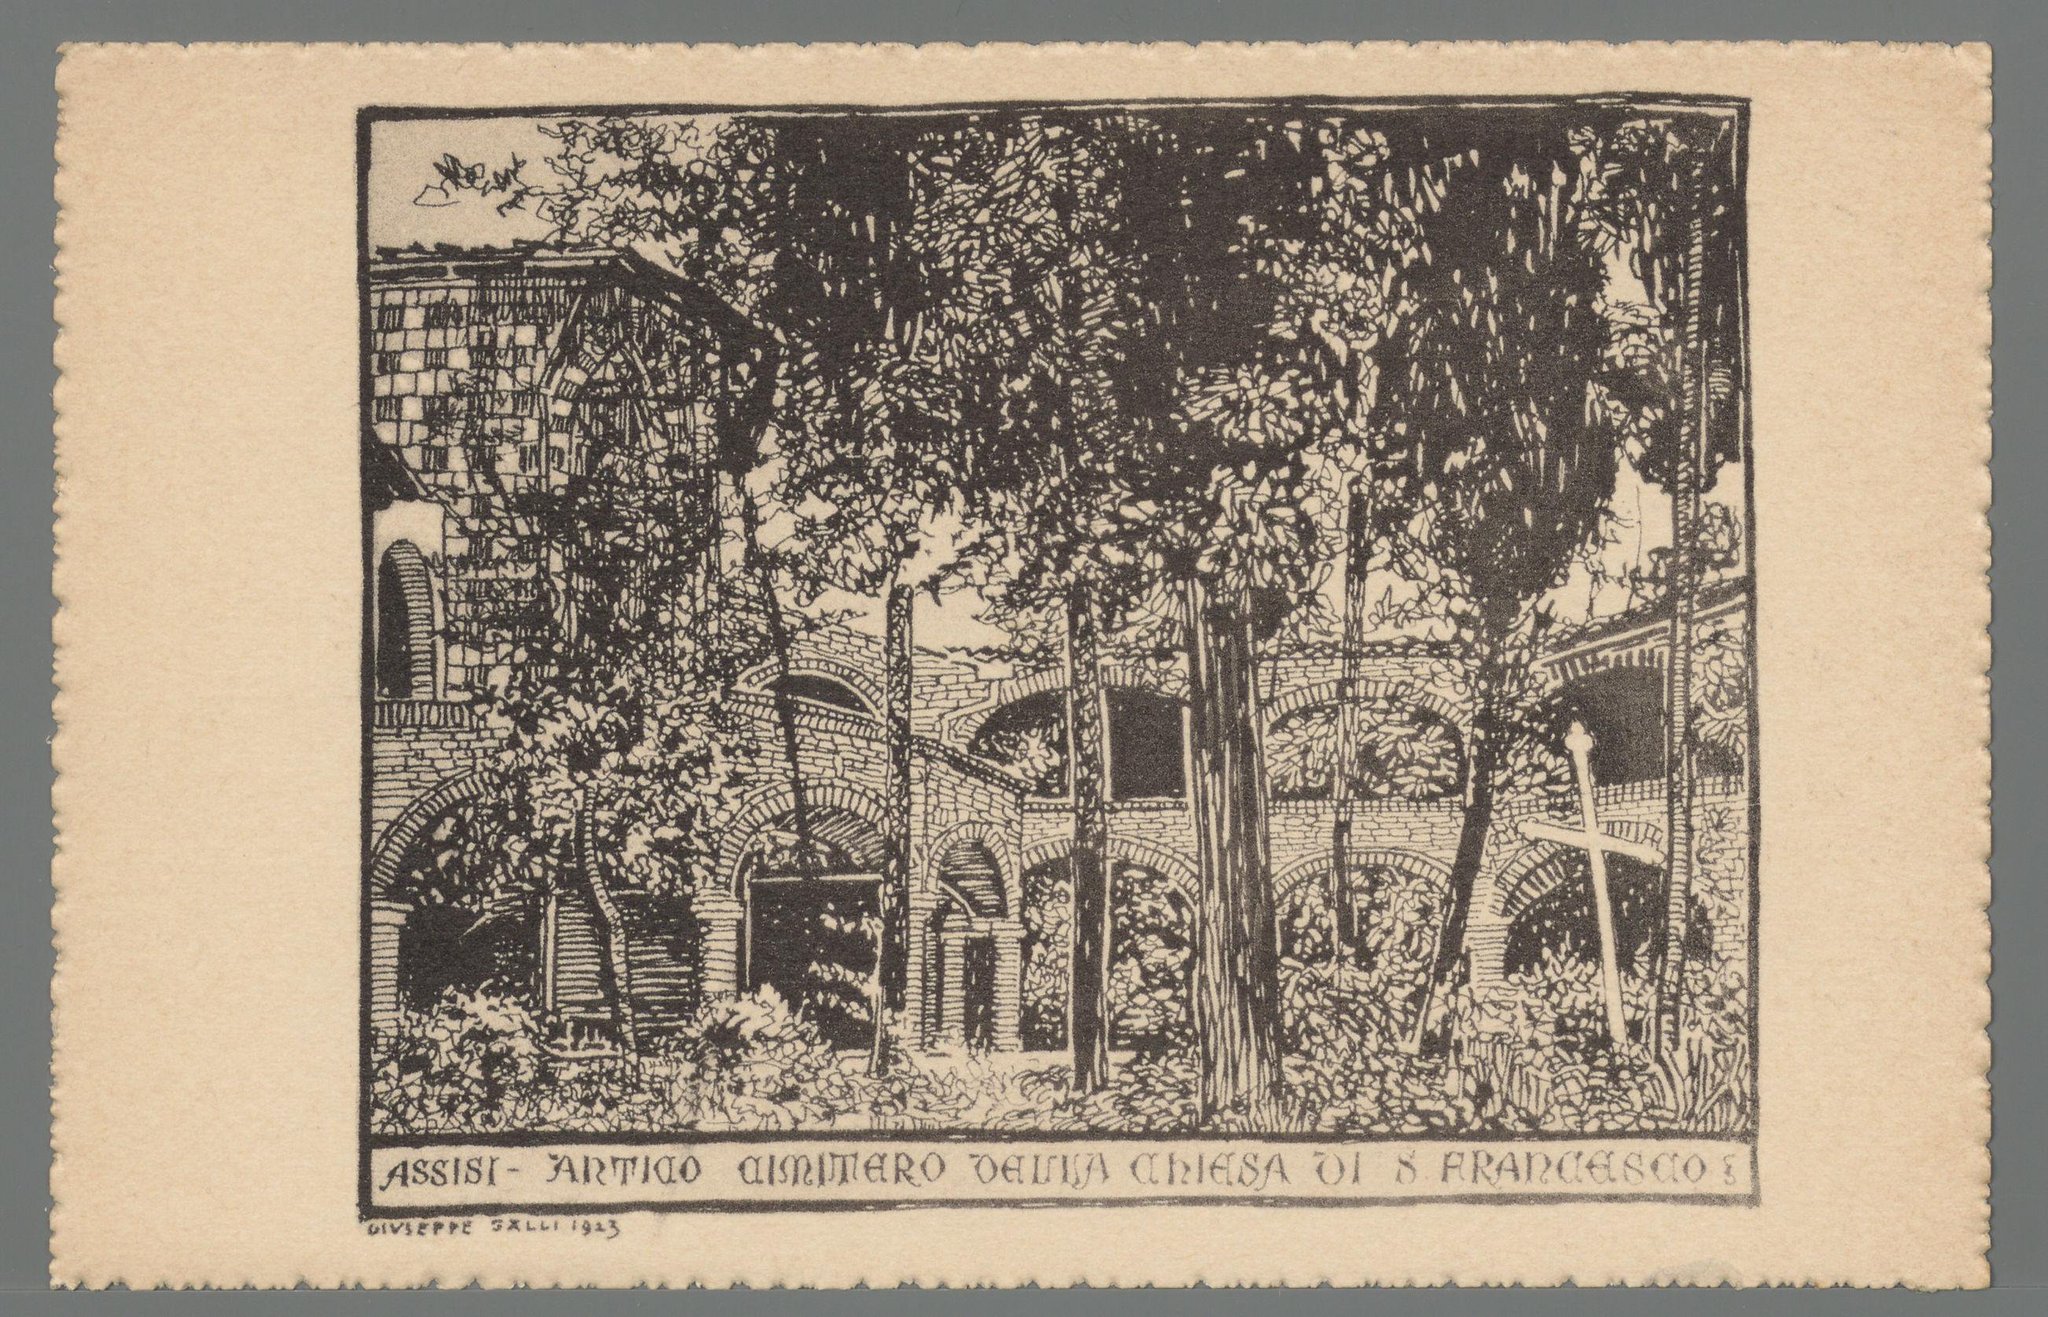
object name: photomechanical print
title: Assisi. Antico cimitero della Chiesa di S. Francesco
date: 1923-1930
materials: cardboard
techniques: photograph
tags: trees, churchyard, cemetery